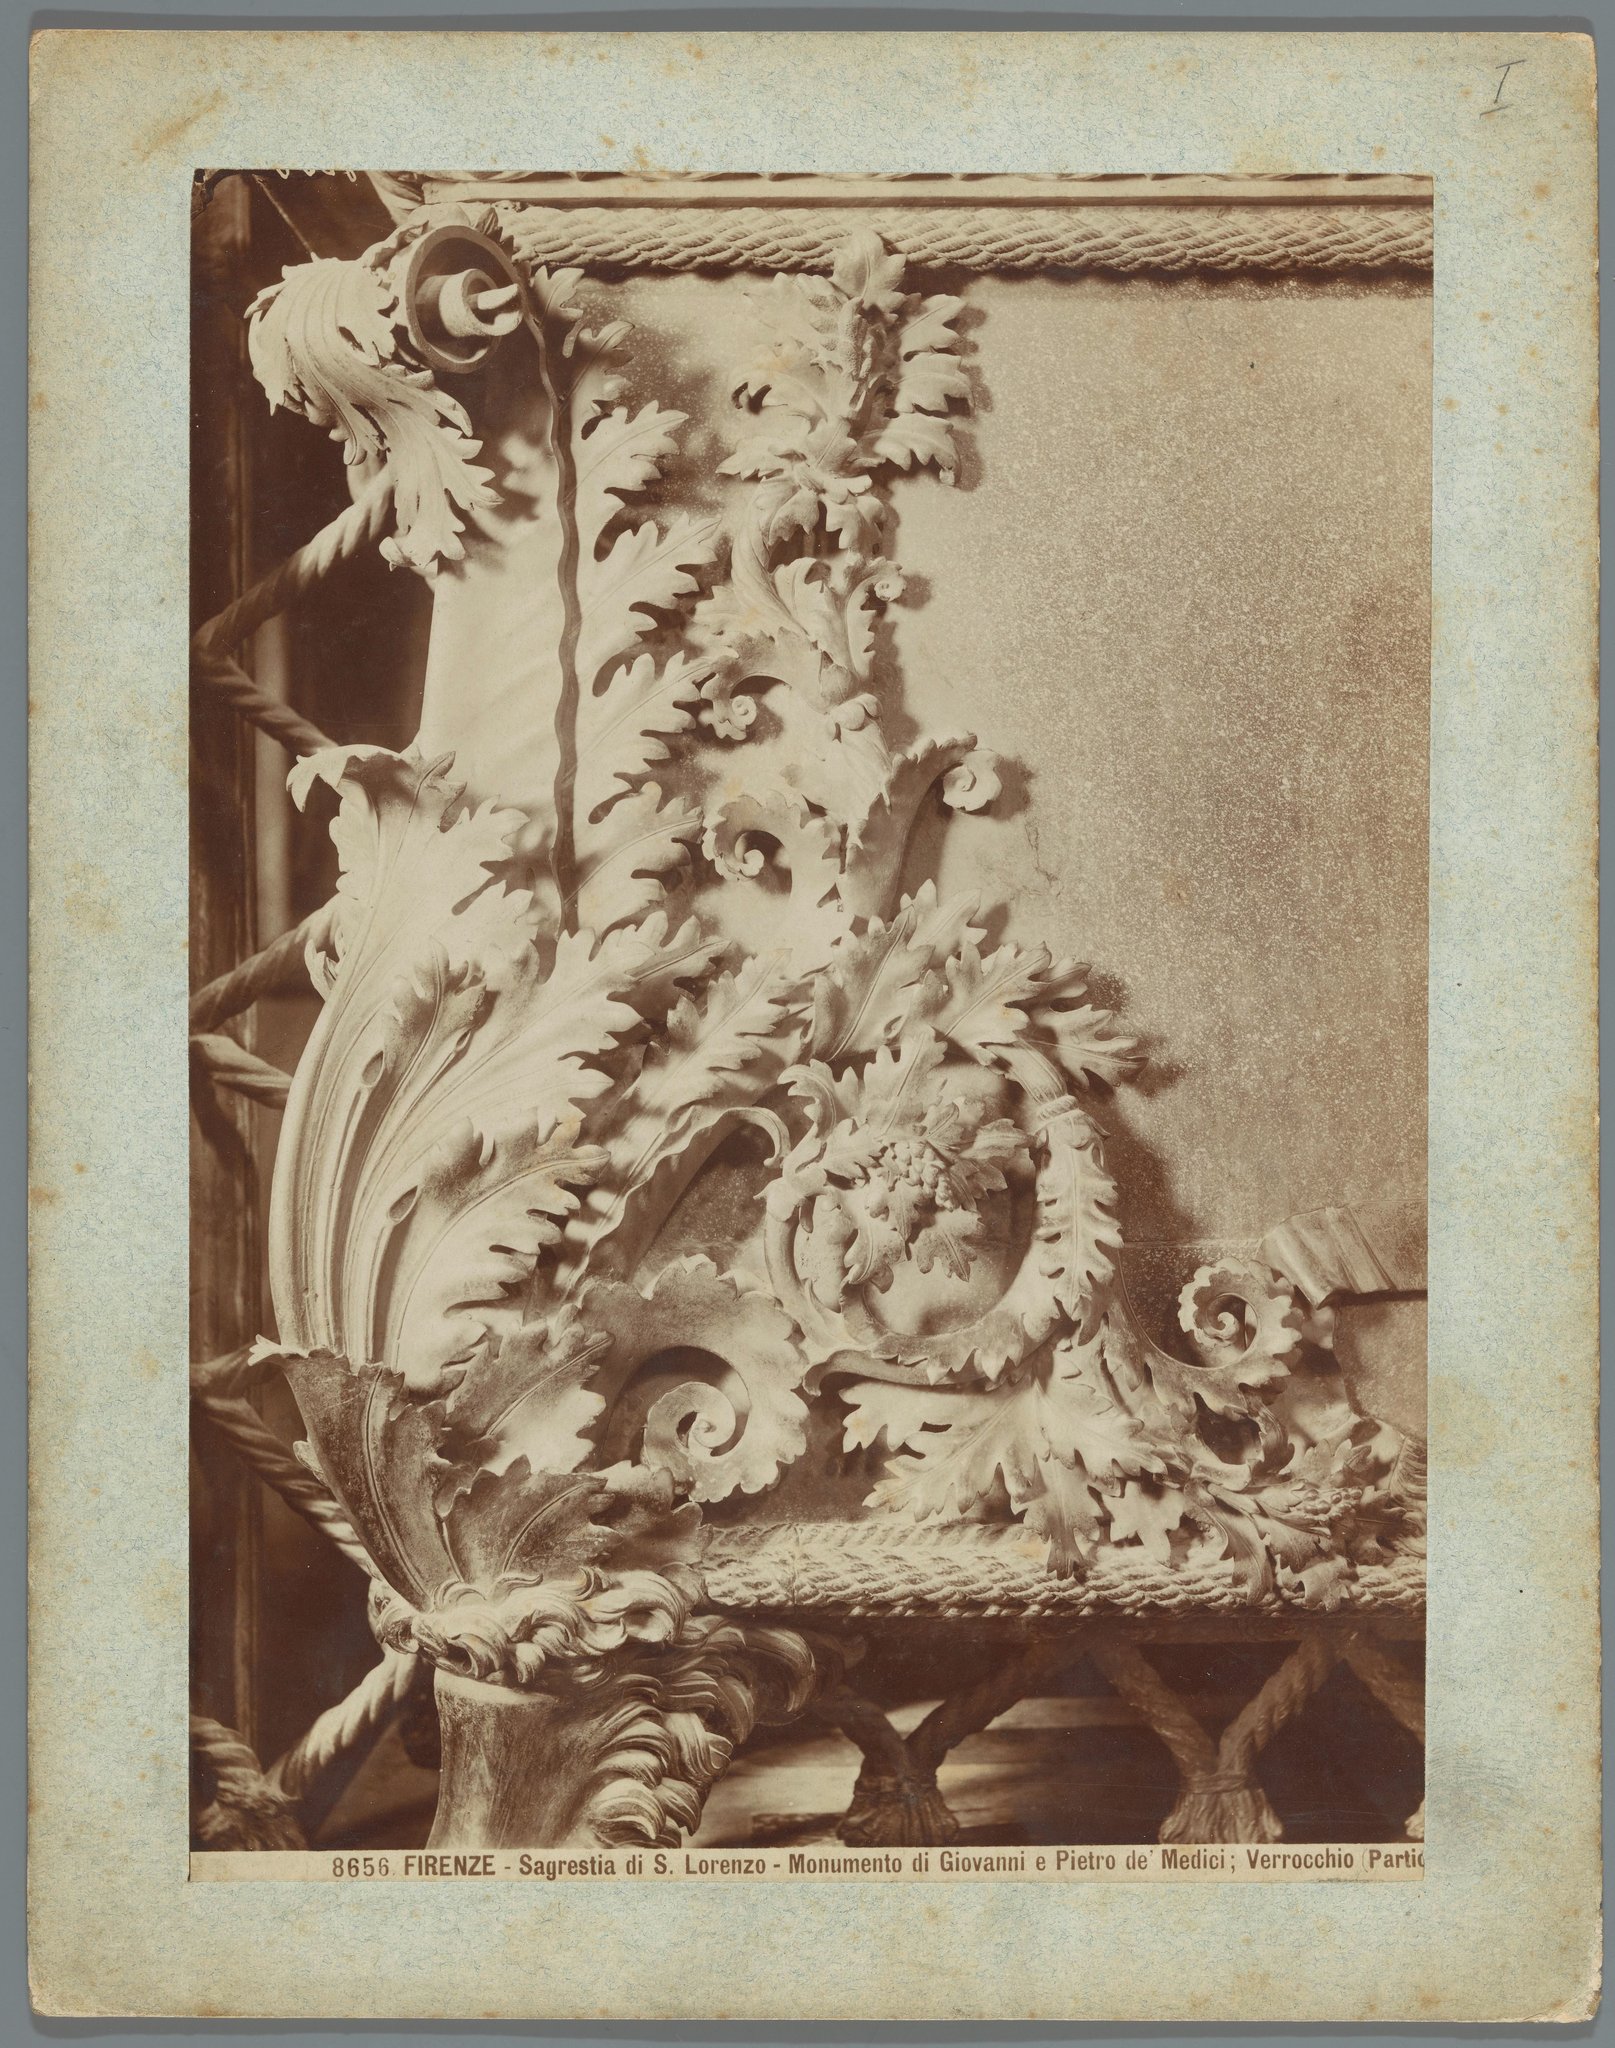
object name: photograph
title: FIRENZE - Sagrestia di S. Lorenzo - Monumento di Giovanni e Pietro de' Medici ; Verrocchio (Partic[(...)]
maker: Anonymous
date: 1875-1900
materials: cardboard, photographic support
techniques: albumen print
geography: sint-laurensbasiliek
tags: acanthus ~ ornament, grave, tomb, interior of church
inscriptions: collector's mark: Lugt 3937, number: ‘8656’